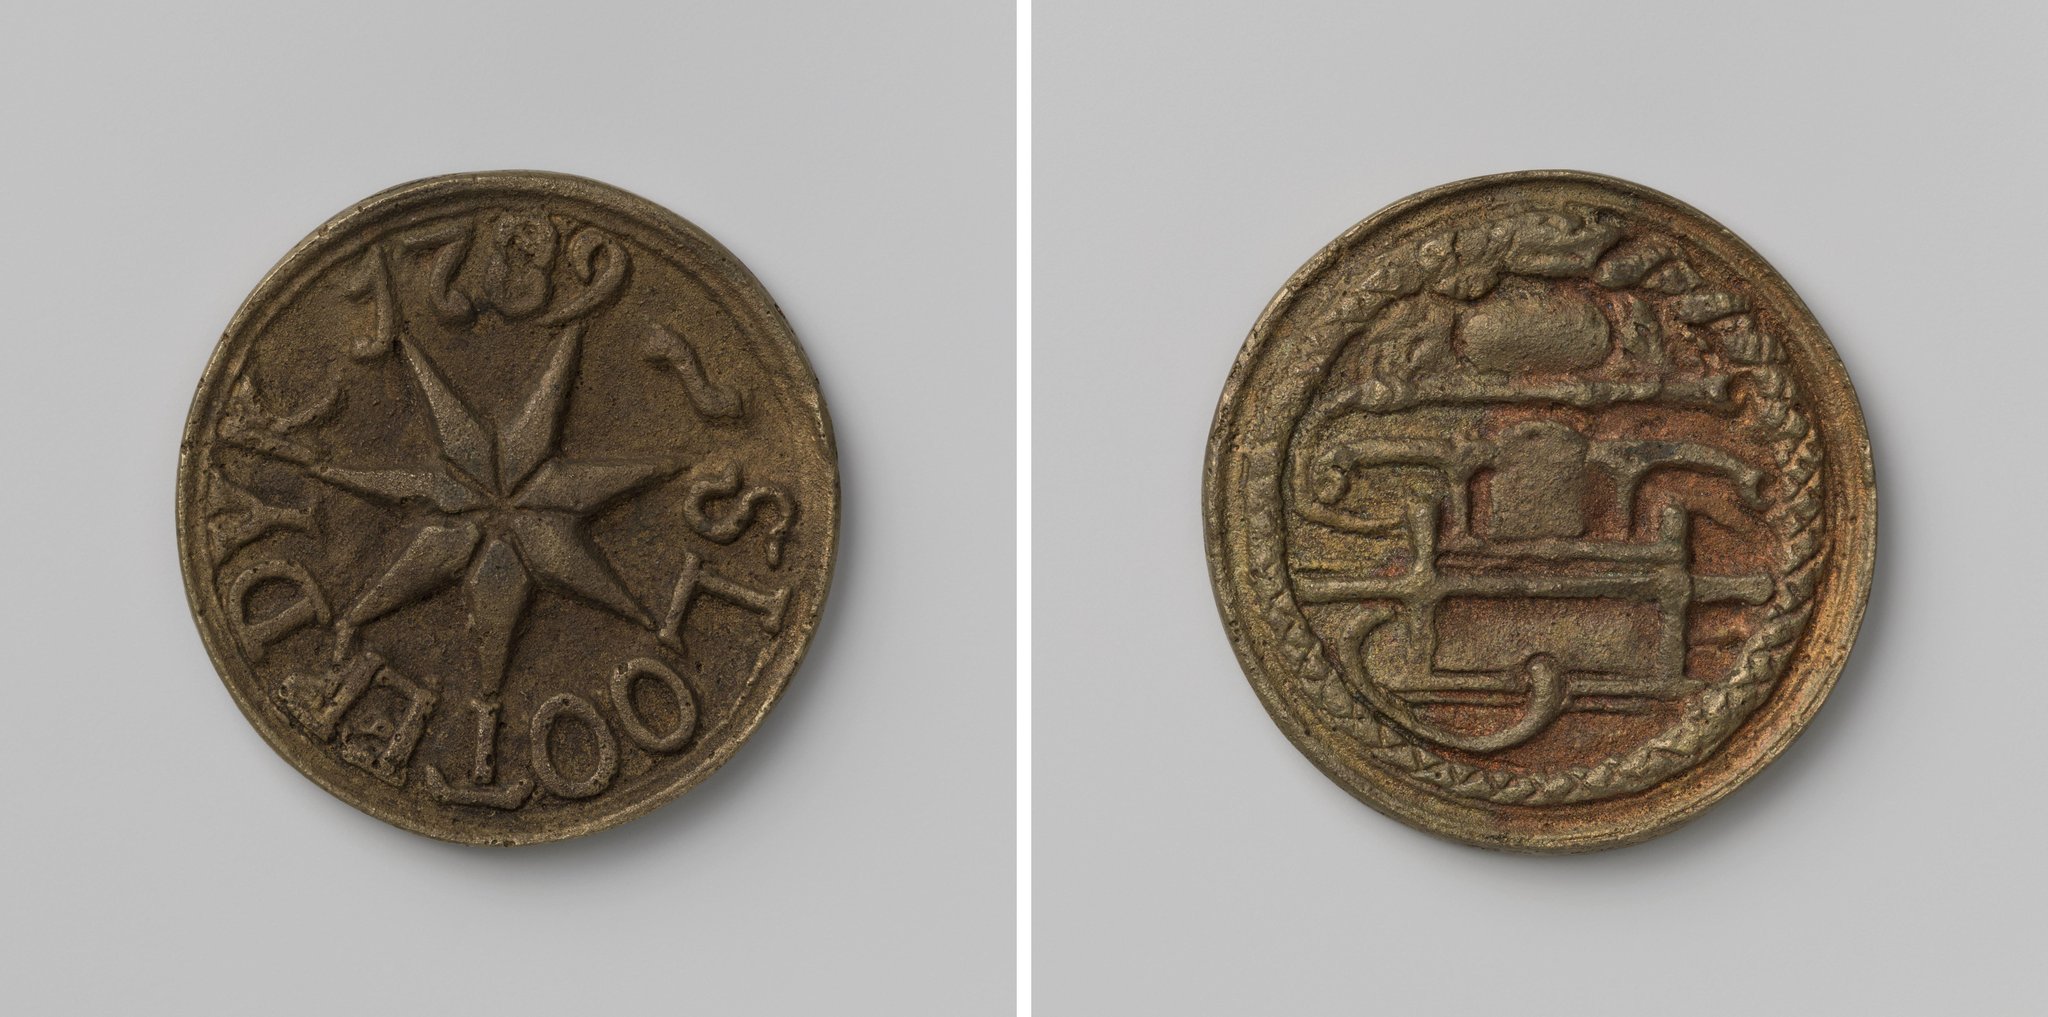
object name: fire engine medal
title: Sloterdijk, brandspuitpenning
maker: Anonymous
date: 1789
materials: brass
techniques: casting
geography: amsterdam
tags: sloterdijk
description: Messing penning. Voorzijde: zevenpuntige ster binnen omschrift. Keerzijde: brandspuit onder leeg cartouche binnen slangerond